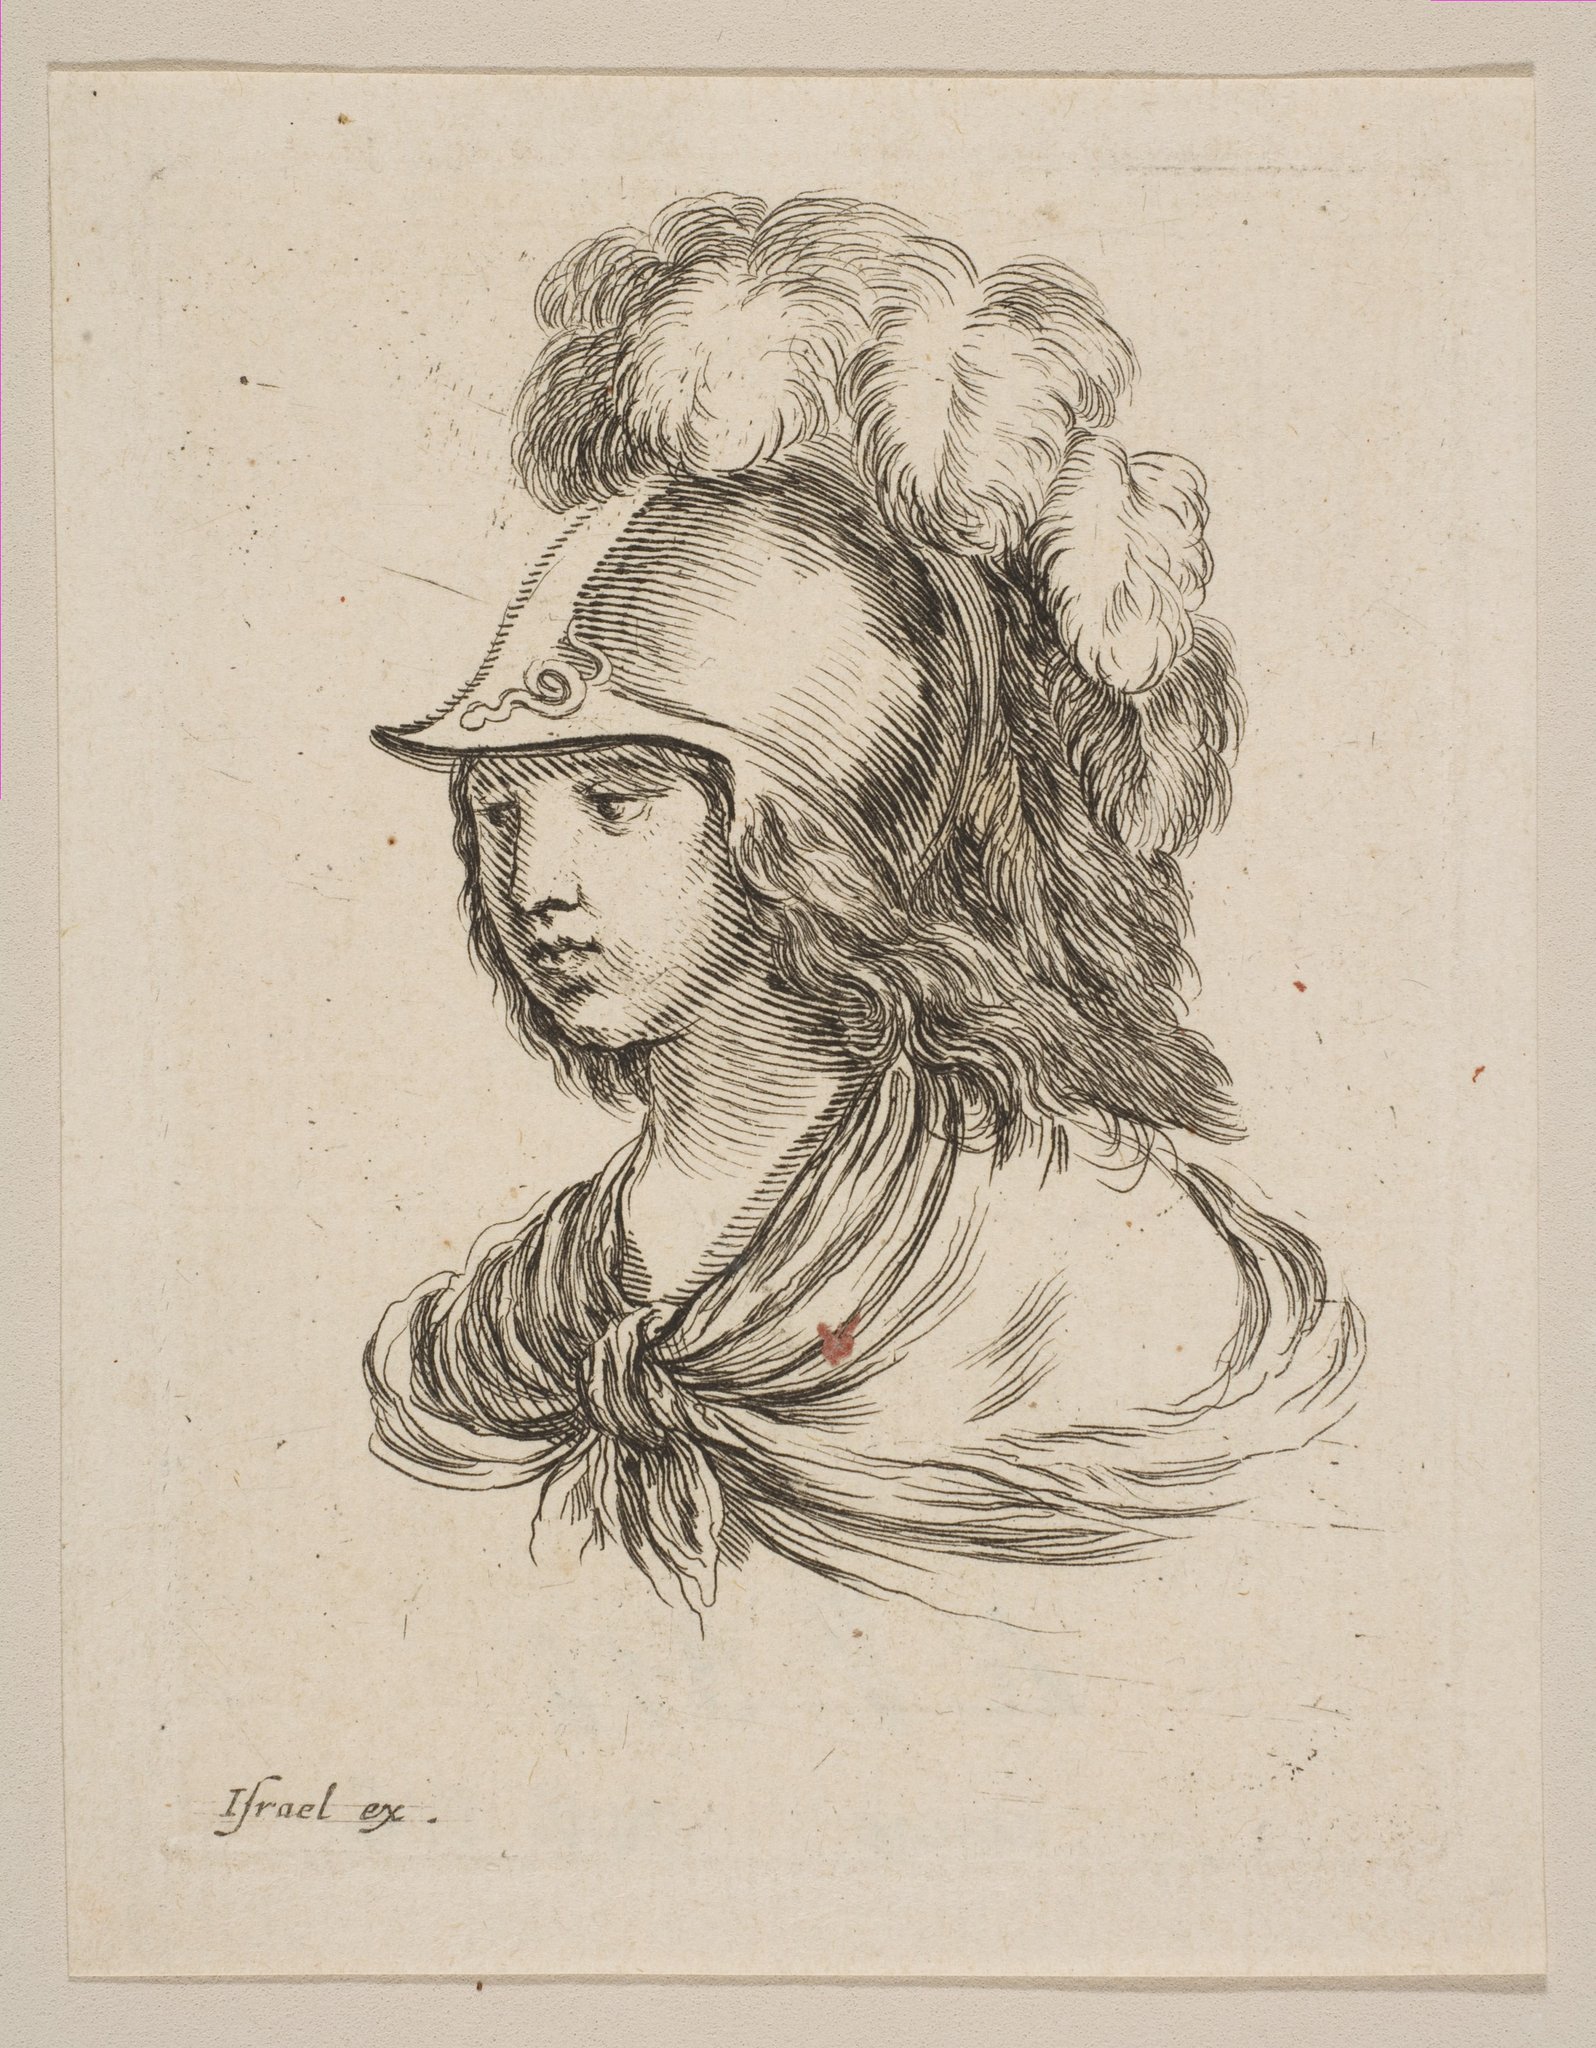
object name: print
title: Head of Minerva, from 'Various heads and figures' (Diverses tétes et figures)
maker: stefano della bella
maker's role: artist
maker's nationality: italian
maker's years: 1610-1664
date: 1650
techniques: etching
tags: heads,portraits,minerva